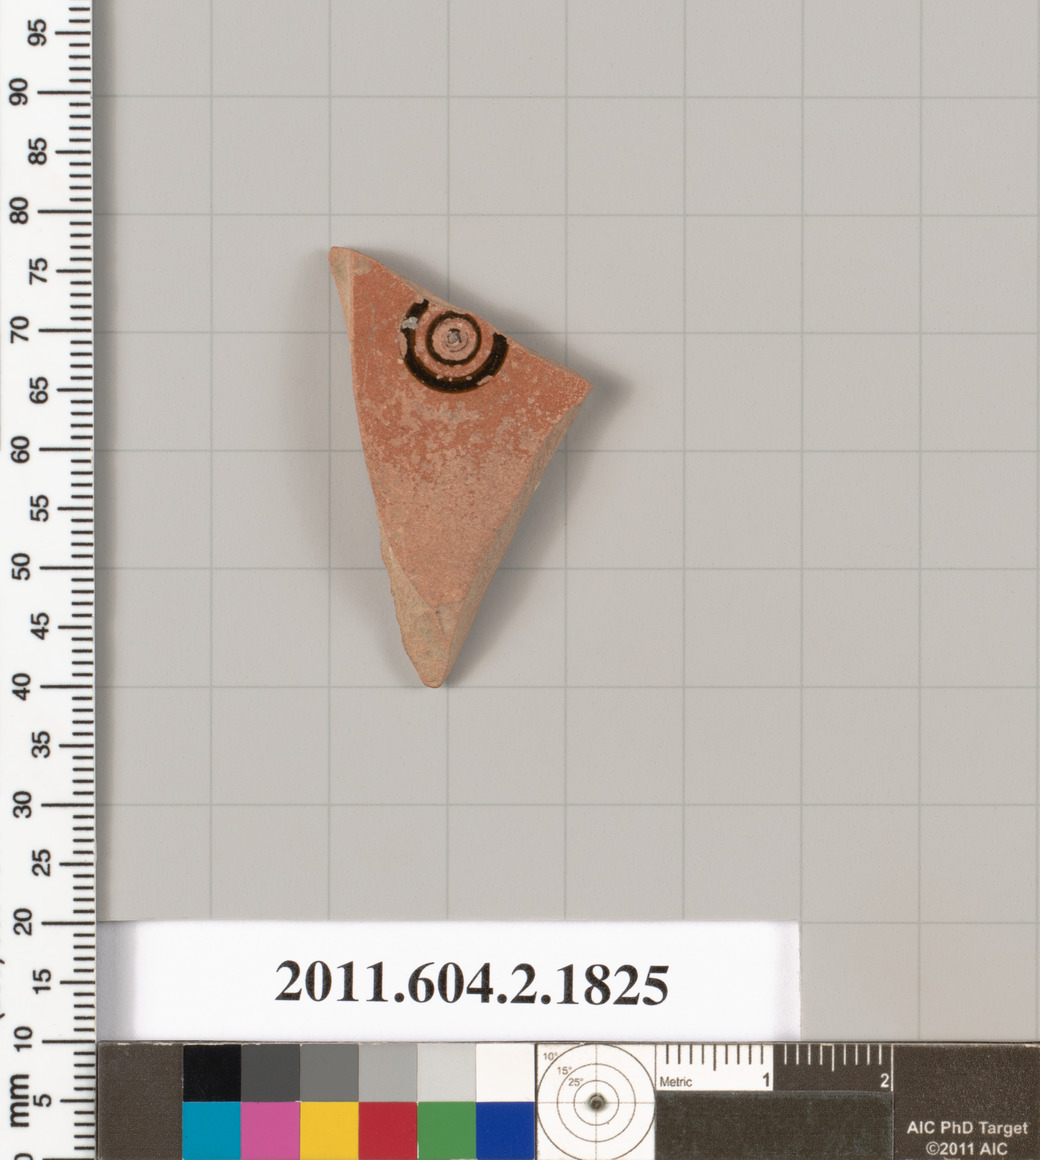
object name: skyphos fragment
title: Terracotta fragment of a skyphos (deep drinking cup)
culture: greek, attic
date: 450-401 BCE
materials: terracotta